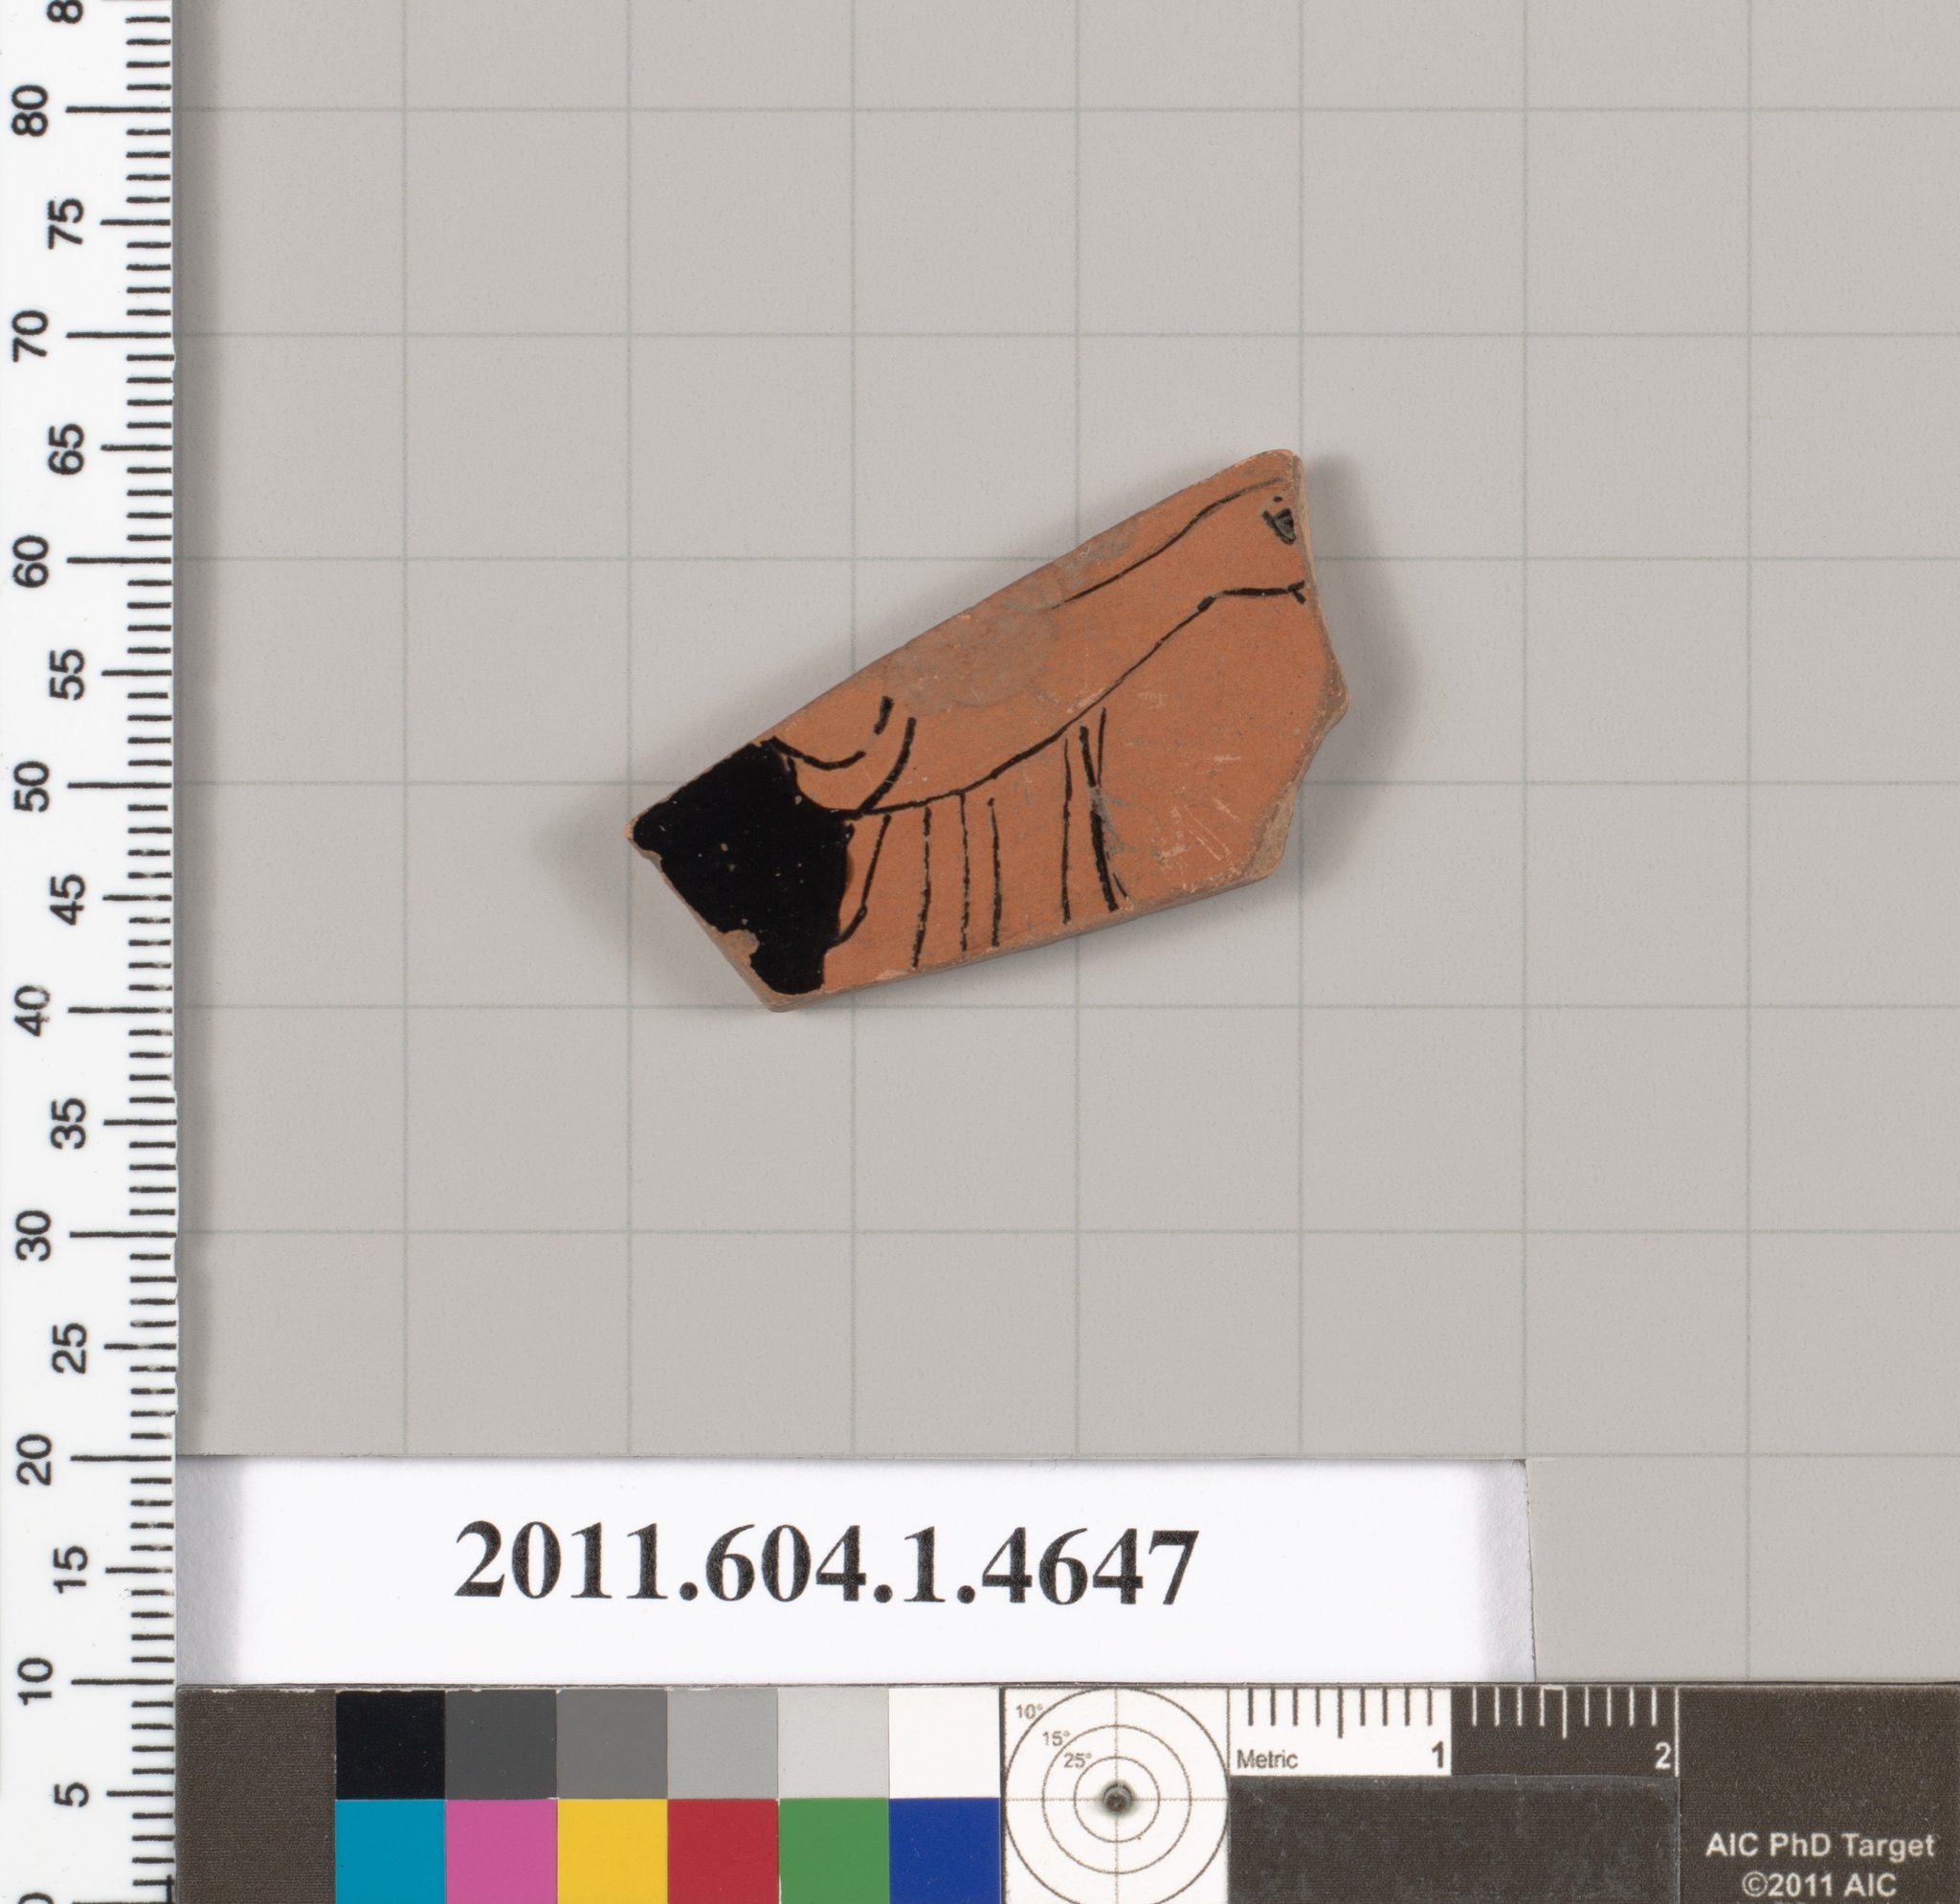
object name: kylix fragment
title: Terracotta fragment of a kylix (drinking cup)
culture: greek, attic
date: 480-470 BCE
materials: terracotta